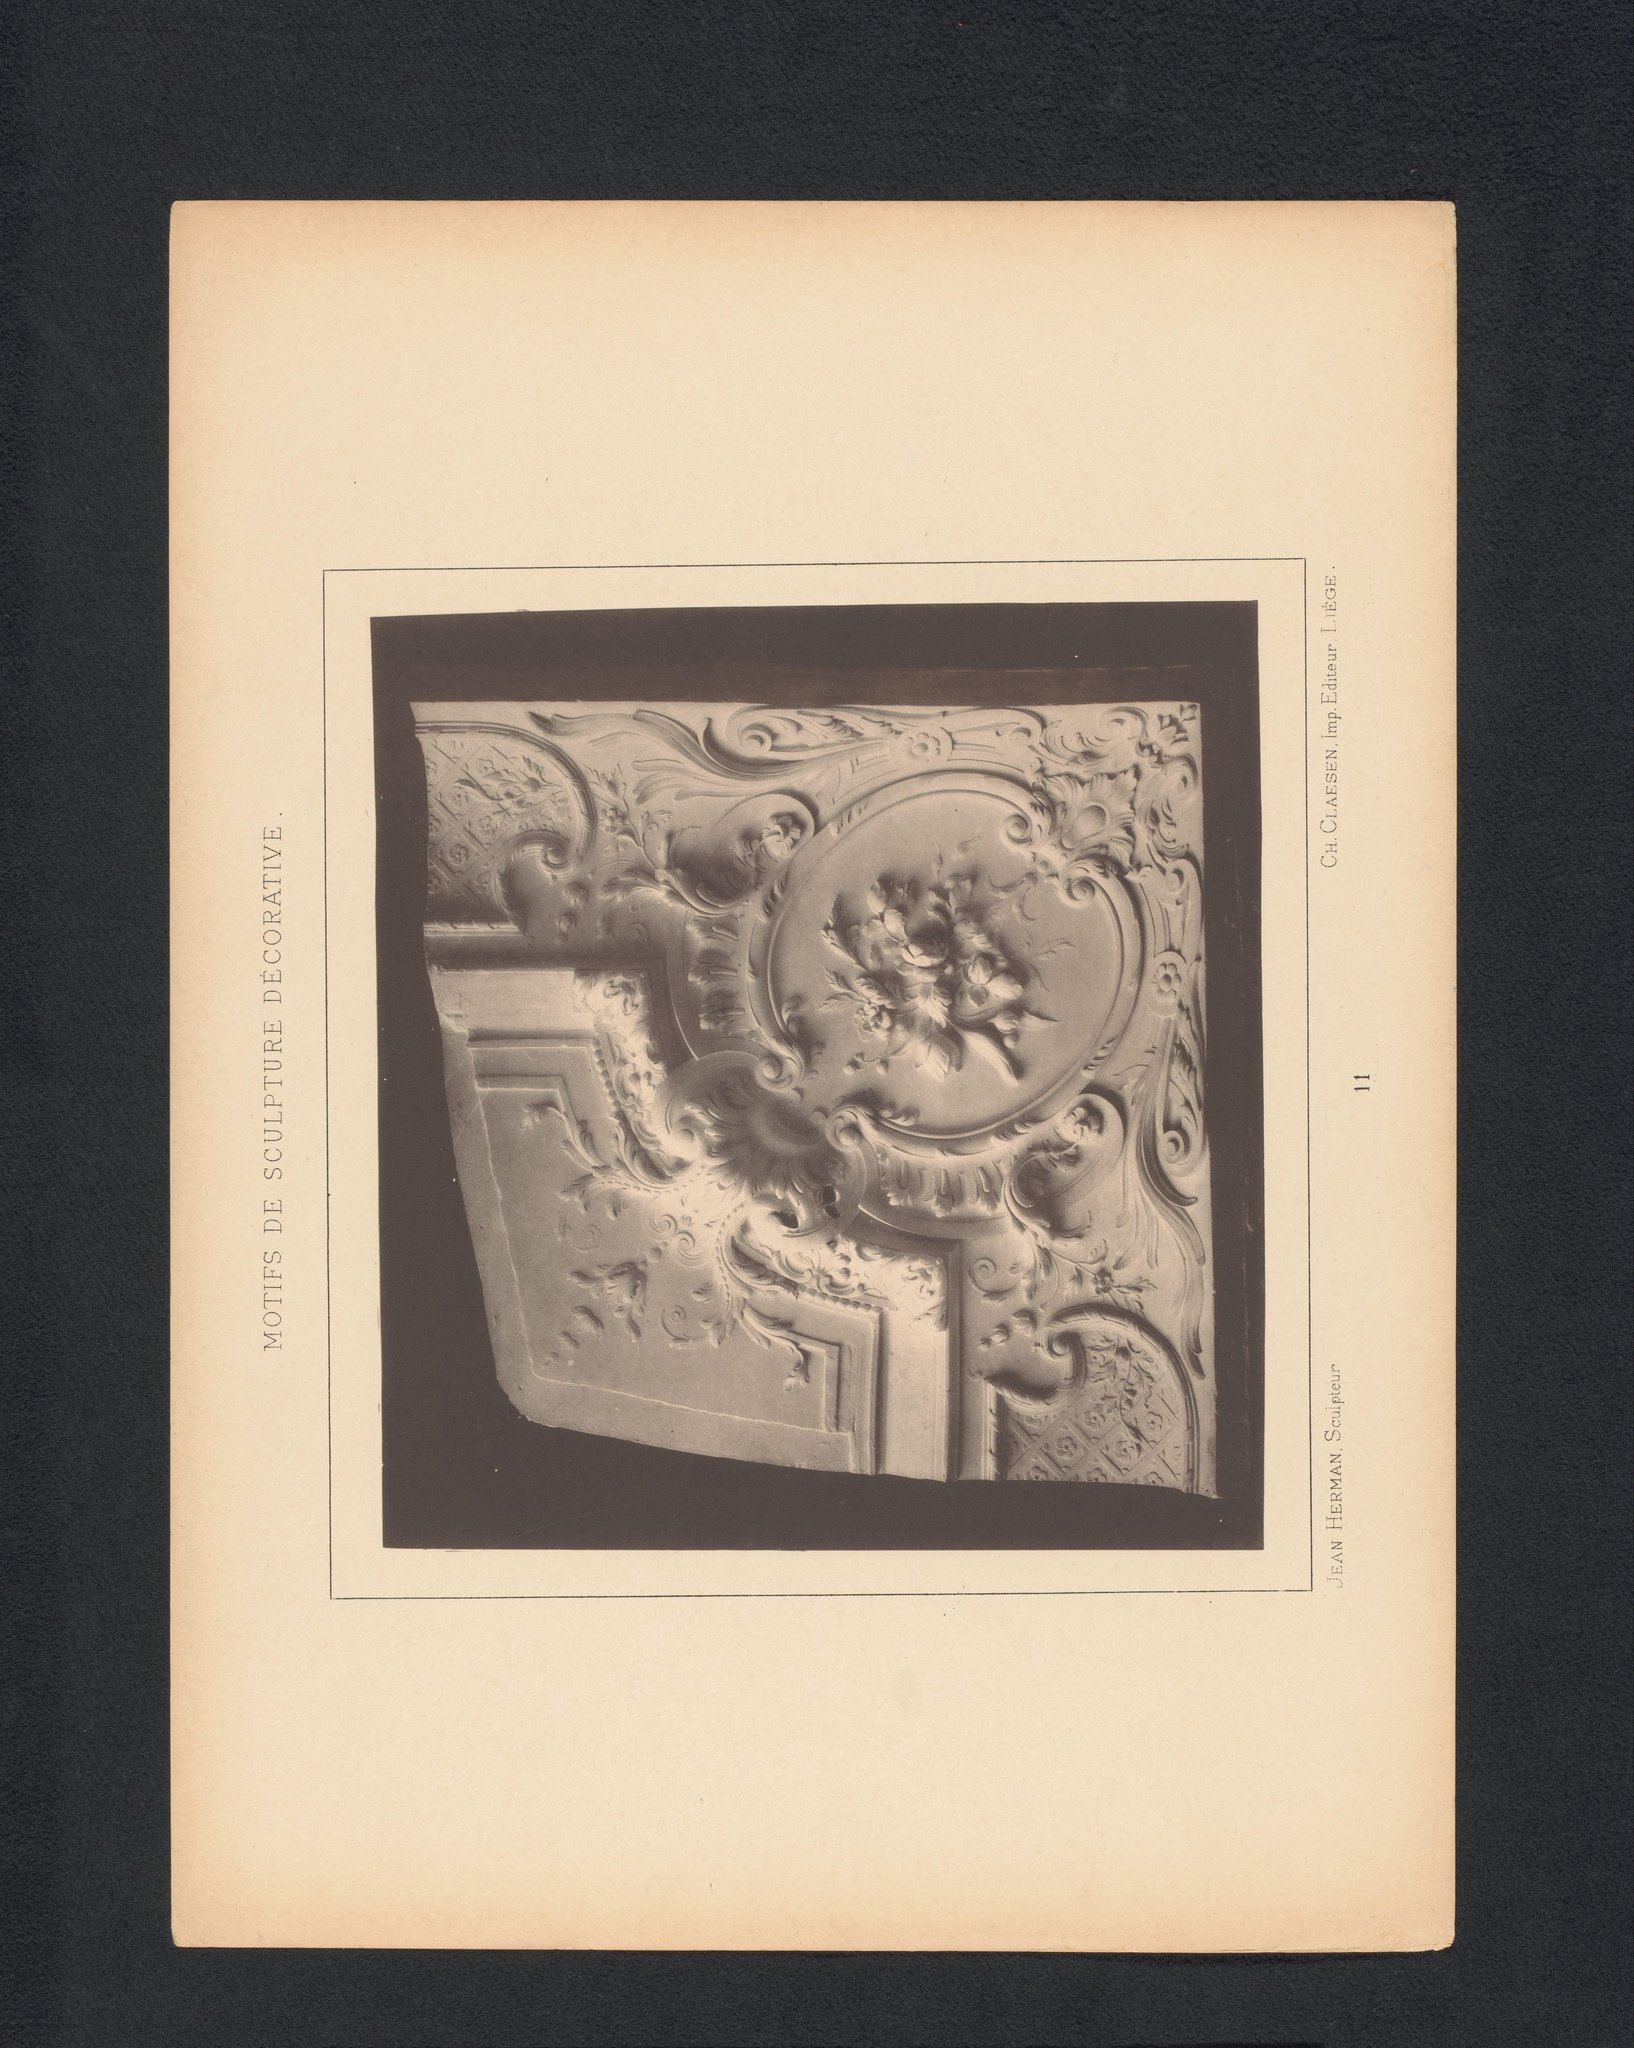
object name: photomechanical print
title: Reliëf met bloemen en bladranken, gebeeldhouwd door Jean Herman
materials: paper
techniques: photograph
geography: liège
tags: ornament derived from plant forms, sculpture (+ relief ~ sculpture)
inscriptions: inscription: ‘Jean Herman, Sculpteur.’, number: ‘11’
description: Deze prent maakt deel uit van een omslag met 28 prenten en een titelblad.